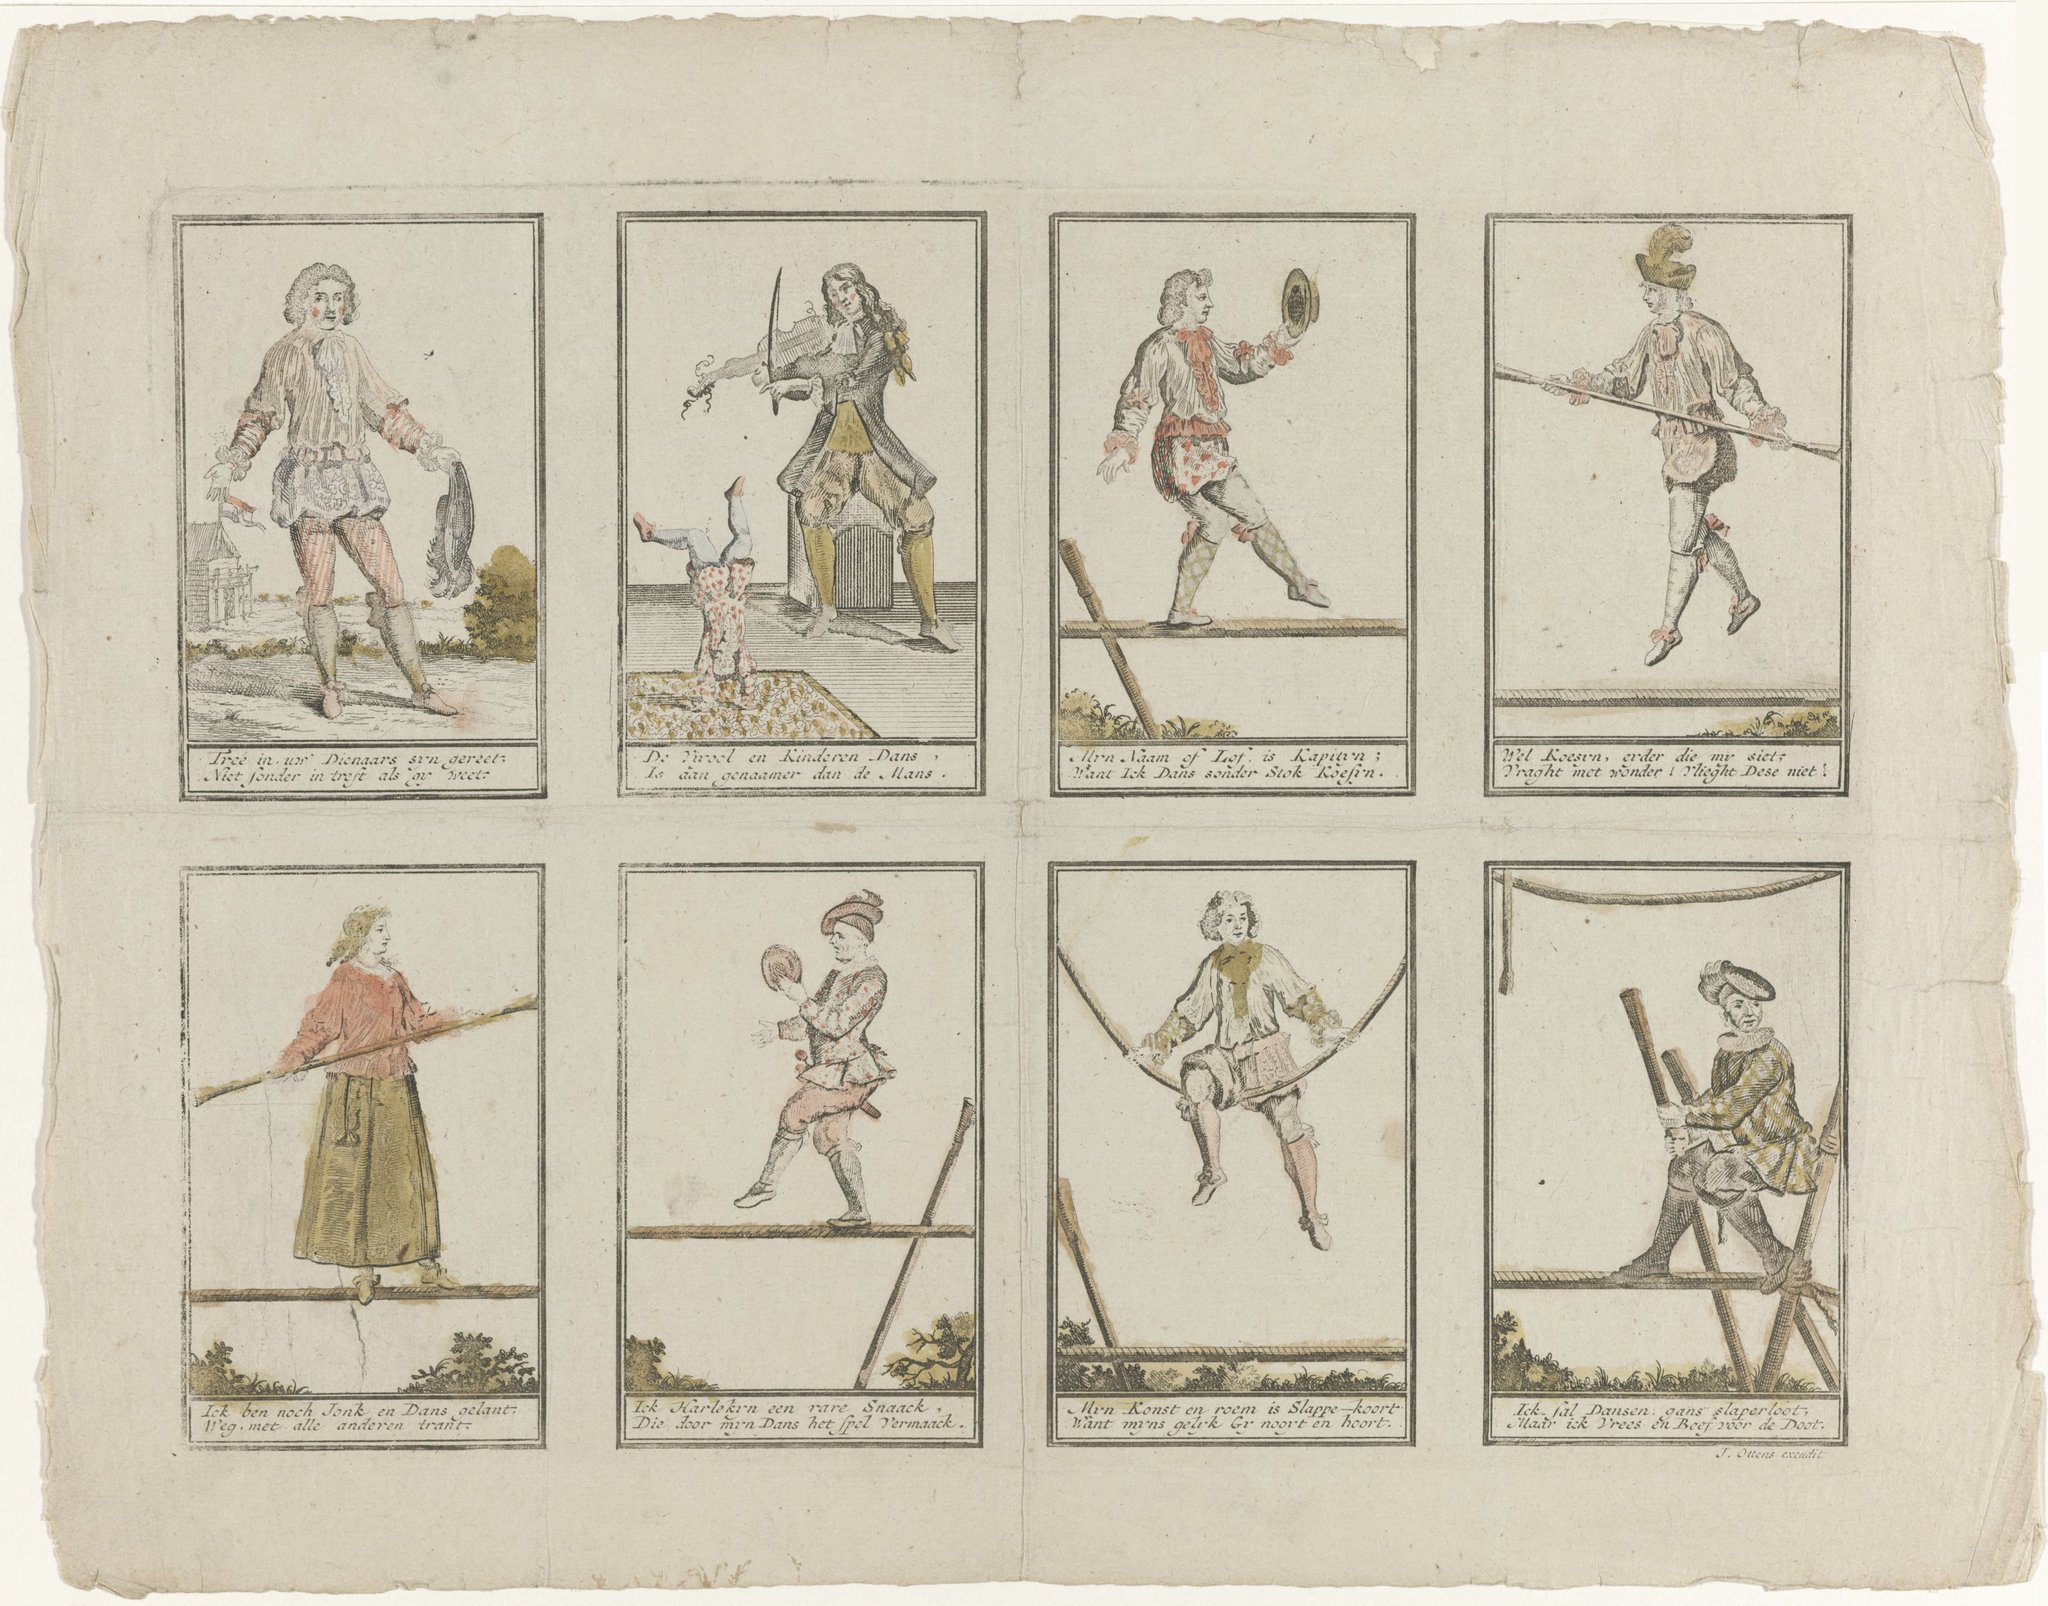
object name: popular print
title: Acht taferelen met kunstenmakers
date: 1689-1720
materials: paper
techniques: colour, engraving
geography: netherlands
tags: musician, violin, fiddle, acrobat ~ circus, ropery, rope-walk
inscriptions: collector's mark: Lugt 2228, collector's mark: Lugt 2760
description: Blad met 8 voorstellingen van kunstenmakers, waaronder acrobaten en muzikanten. Onder elke afbeelding een tweeregelig vers.